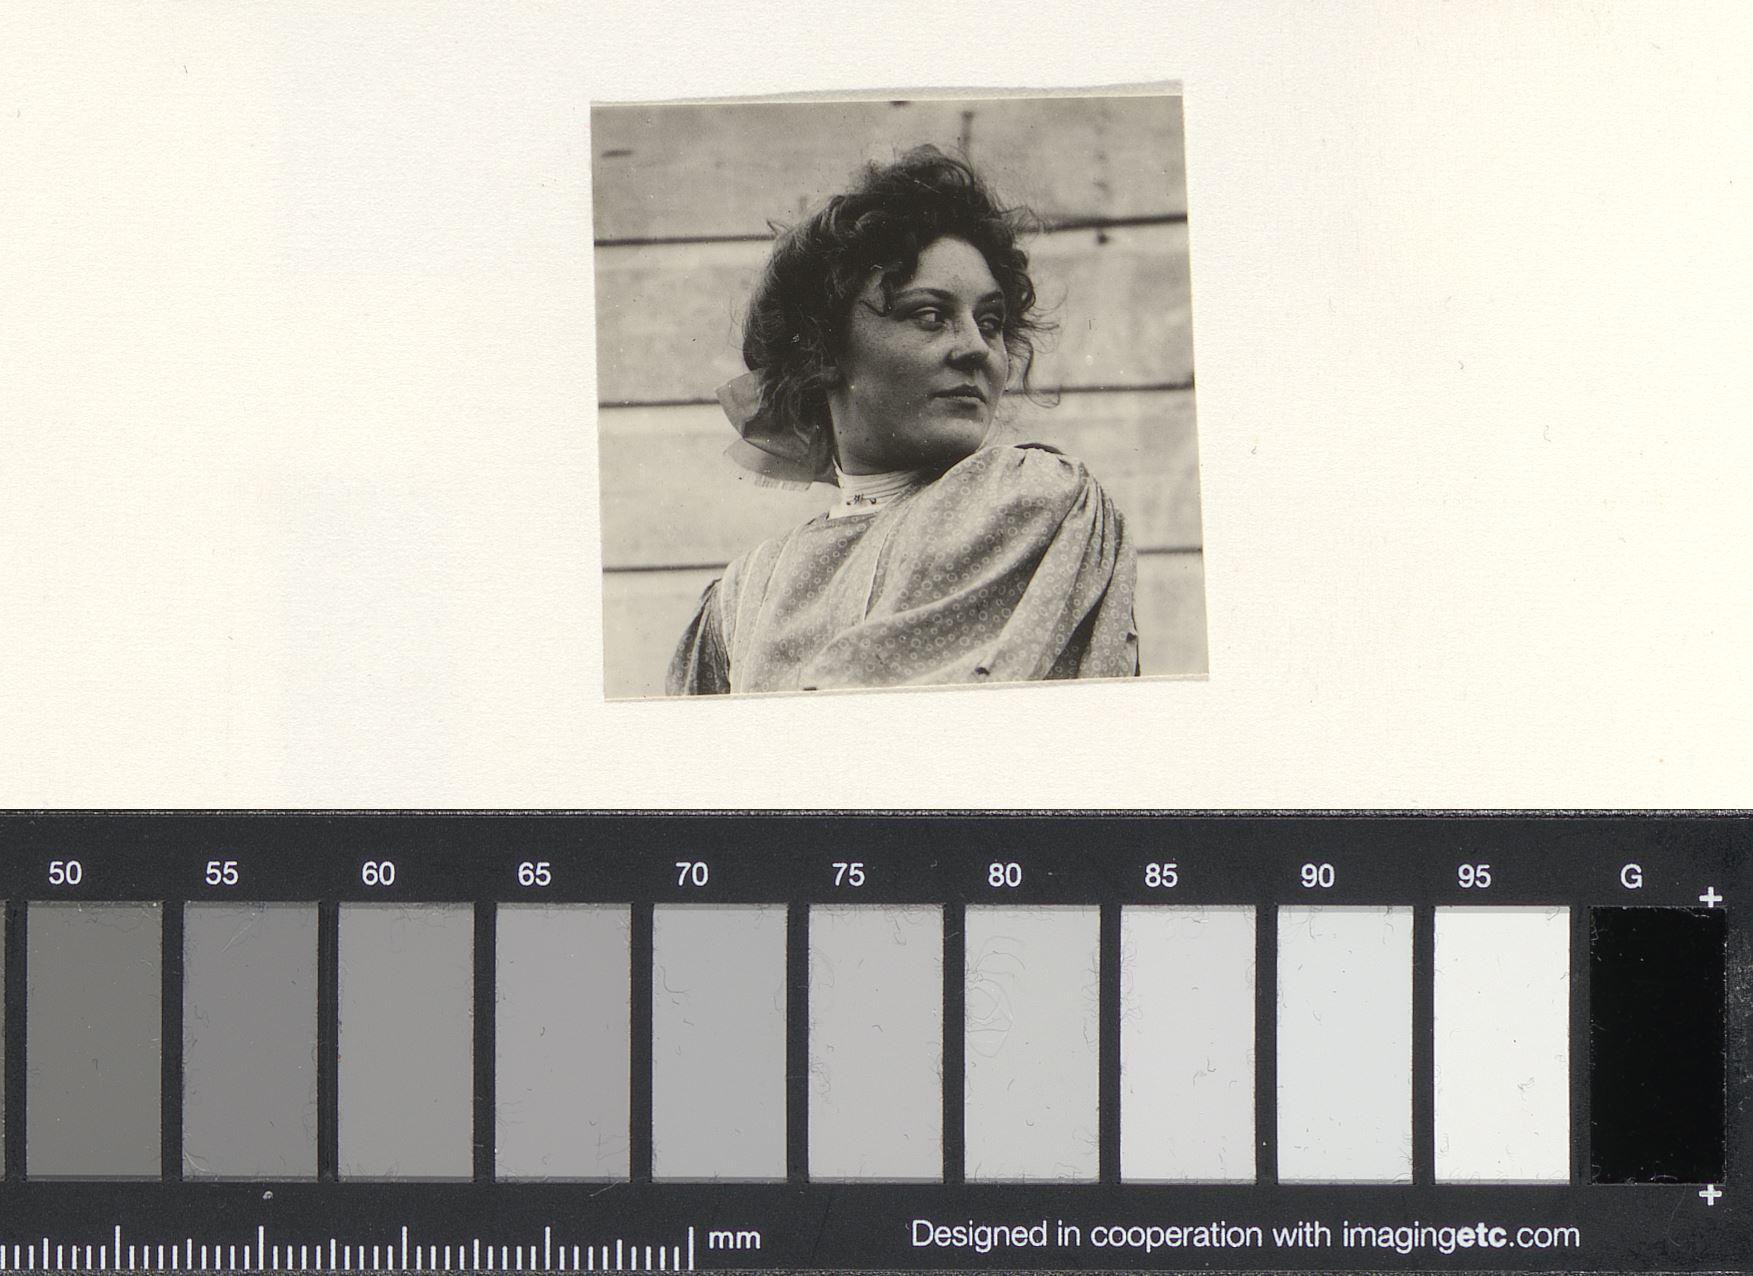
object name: album leaf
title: Portret van een onbekende vrouw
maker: george hidderley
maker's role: fotograaf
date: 1900-1910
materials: paper, photographic support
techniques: gelatin silver print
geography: volendam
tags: adult woman, historical persons